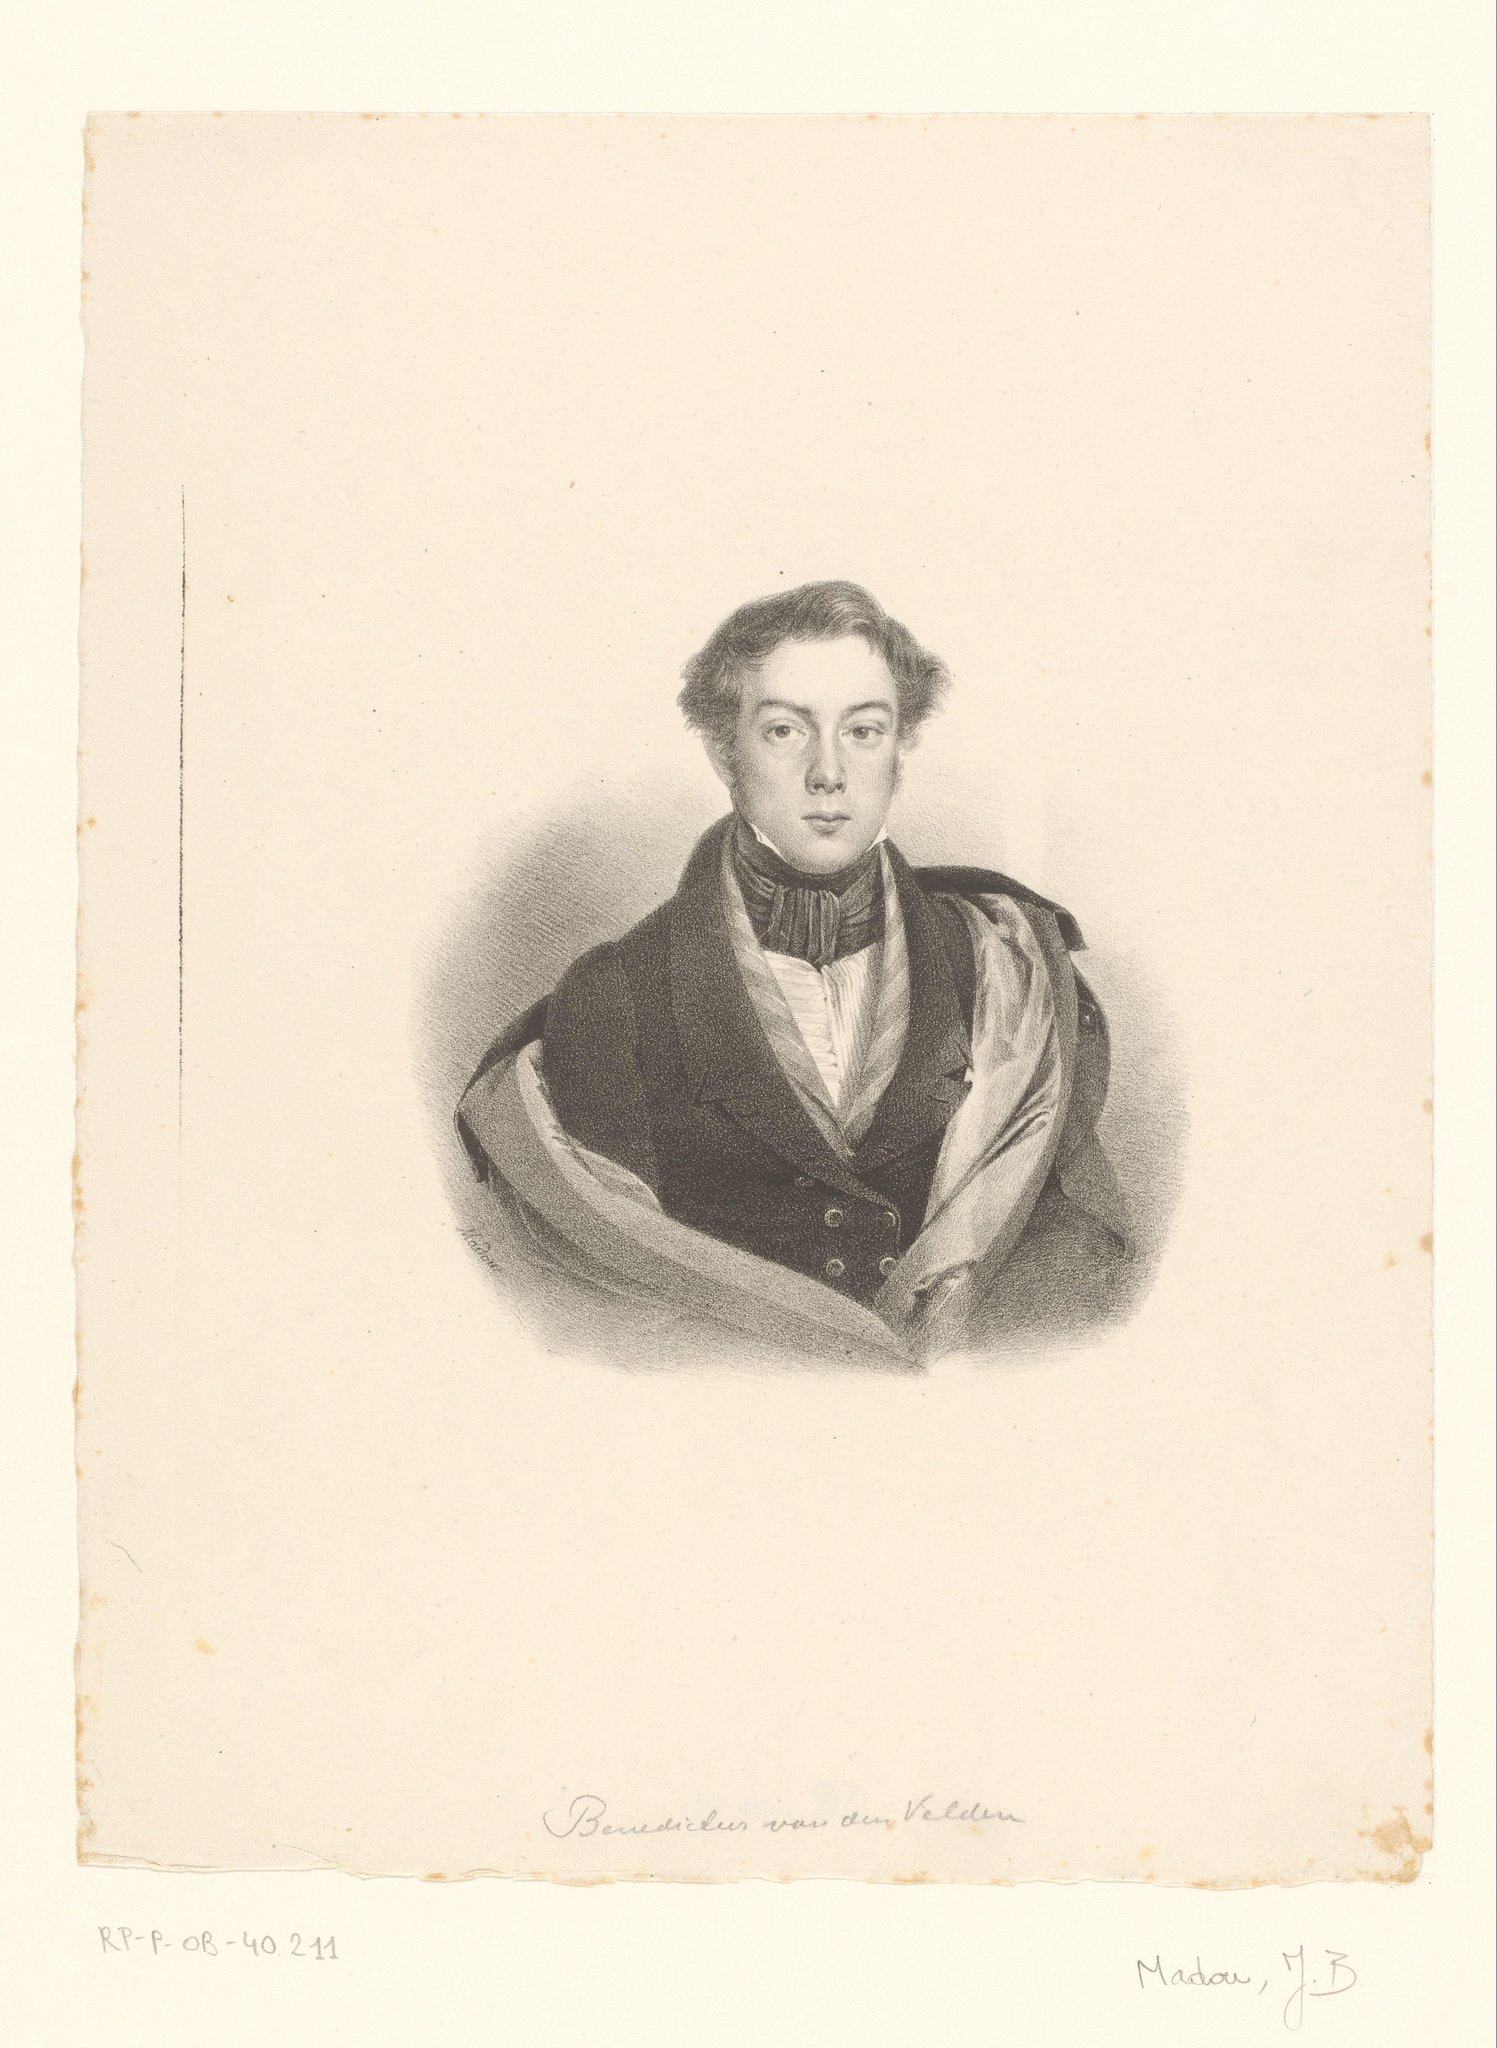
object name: print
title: Portret van een onbekende man, mogelijk Benedictus van den Velden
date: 1806-1877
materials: paper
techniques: lithograph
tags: adult man, historical persons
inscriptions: inscription: ‘Benedictus van den Velden’